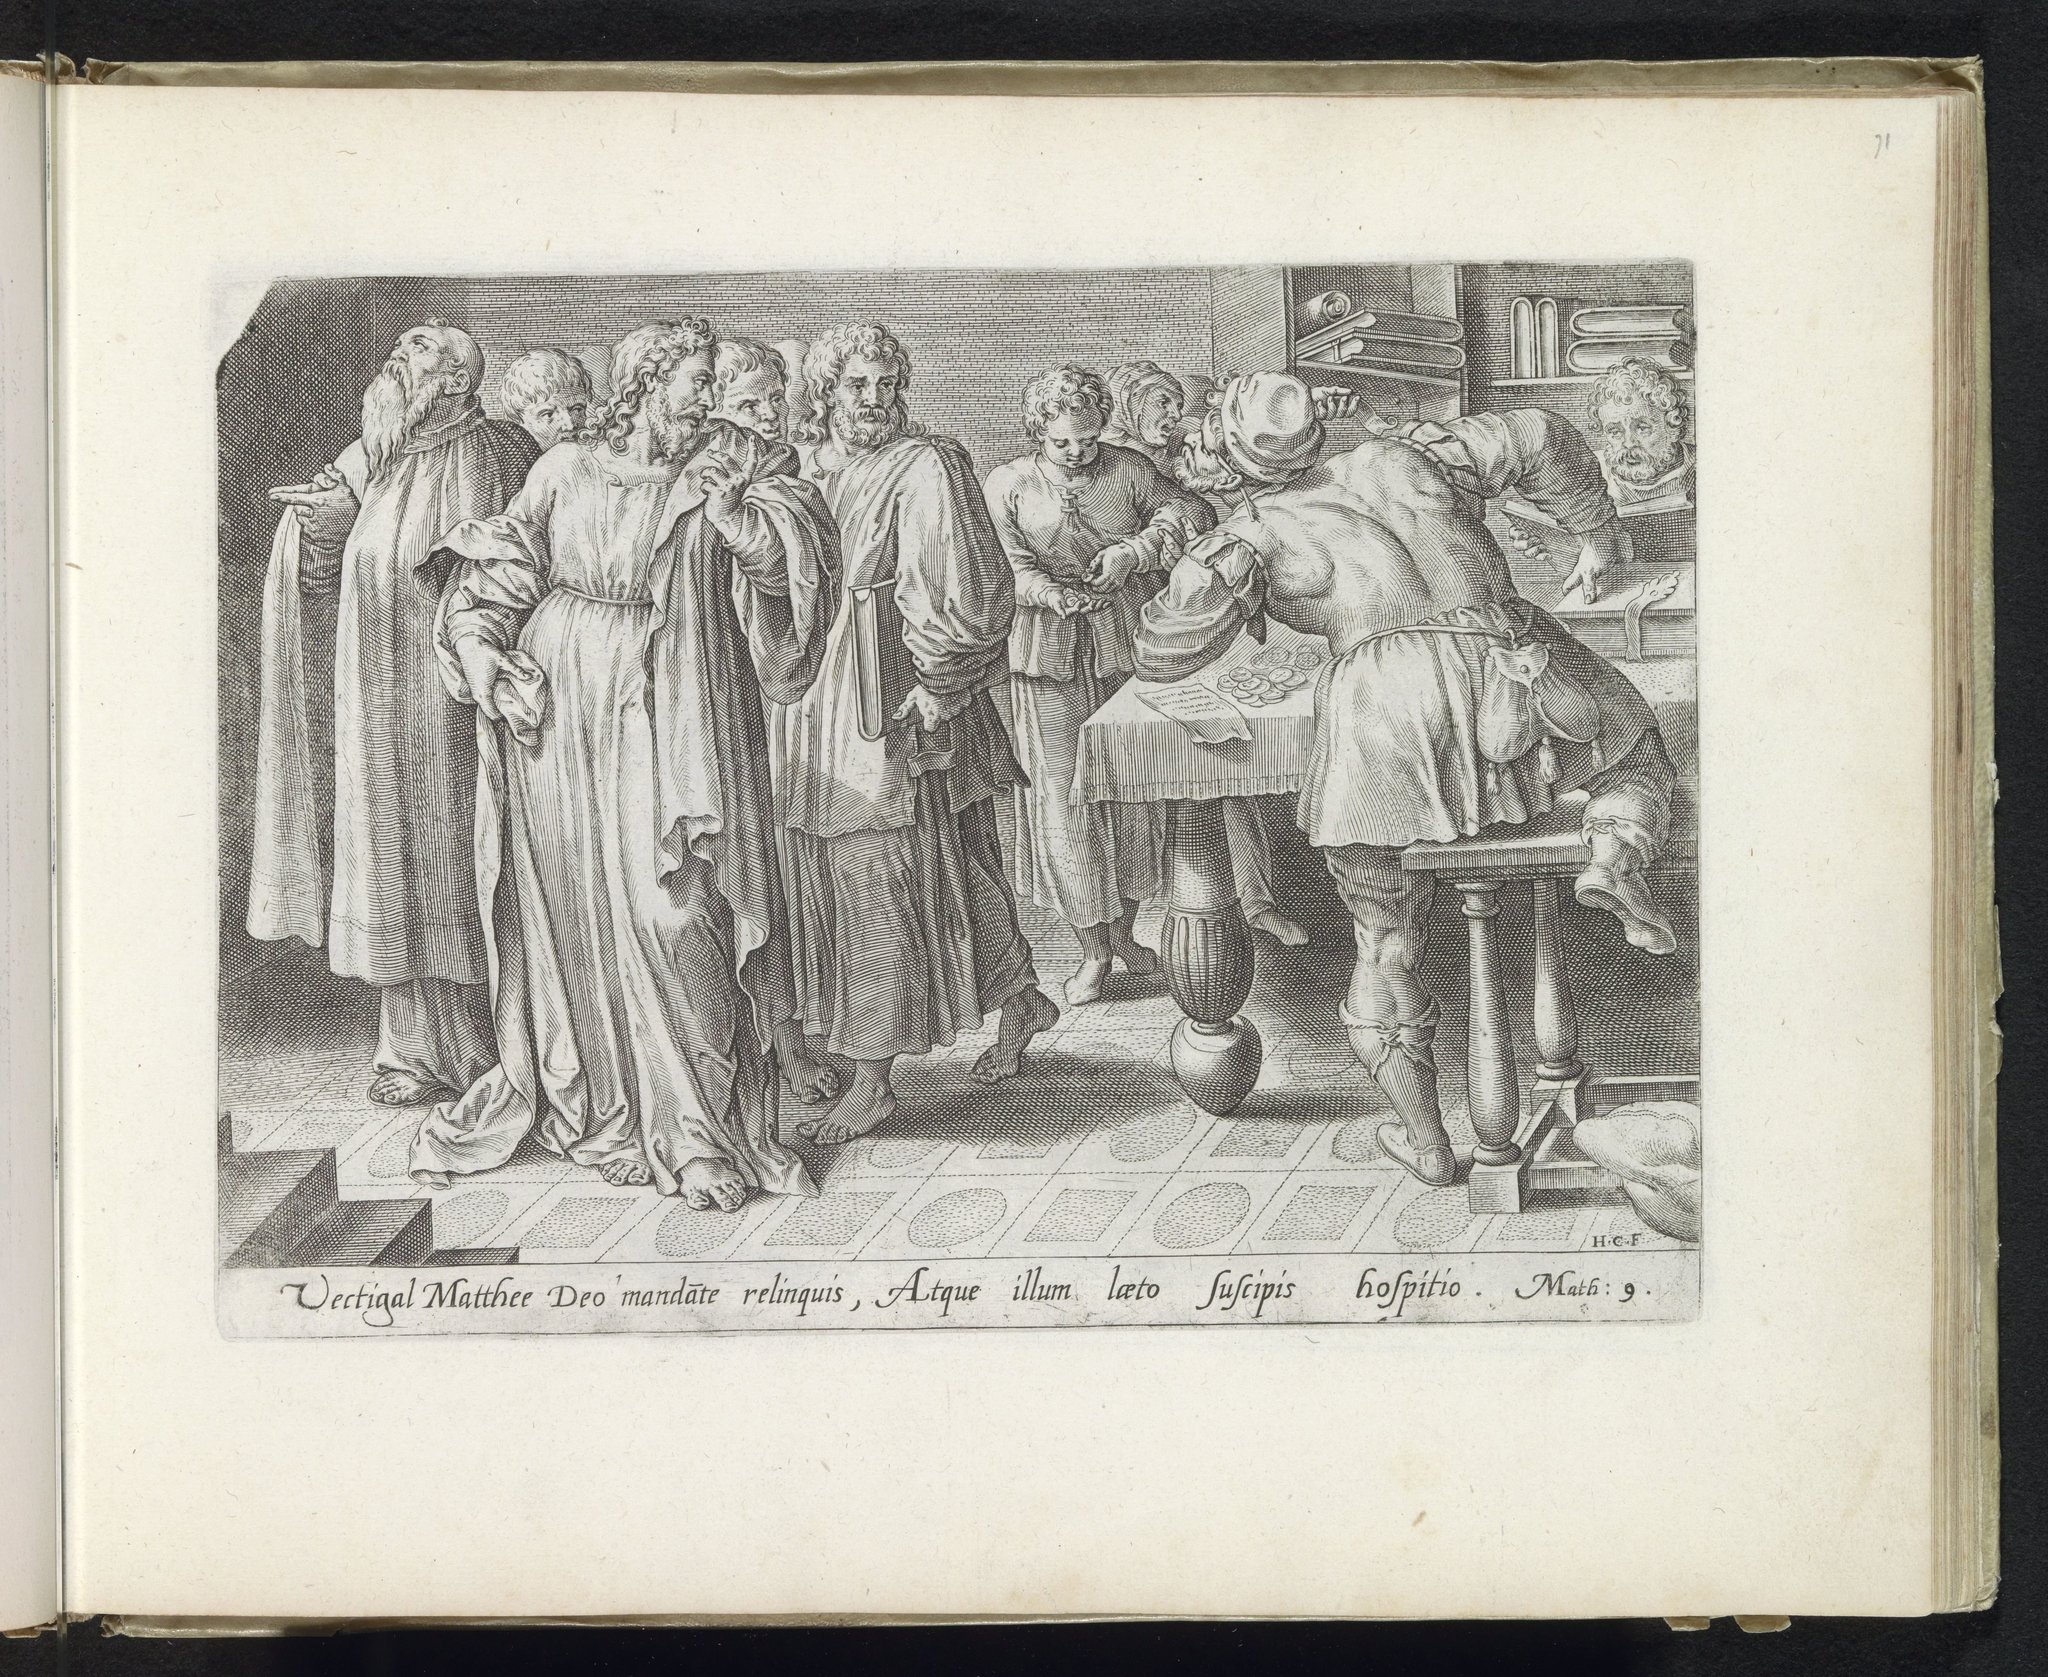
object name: album leaf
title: Roeping van Matteüs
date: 1585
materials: paper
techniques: engraving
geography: antwerp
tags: calling of matthew (levi), the tax-collector (usually with money lying on the table and people paying taxes) (matthew 9:9; mark 2:14; luke 5:27-28)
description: Christus passeert met zijn leerlingen de tollenaar Matteüs en vraagt hem hem te volgen. Matteüs staat op van zijn bank en verlaat de tafel waar hij belasting int. Onder de voorstelling een verwijzing in het Latijn naar de Bijbeltekst in Mat. 9. Deze prent maakt deel uit van een album.